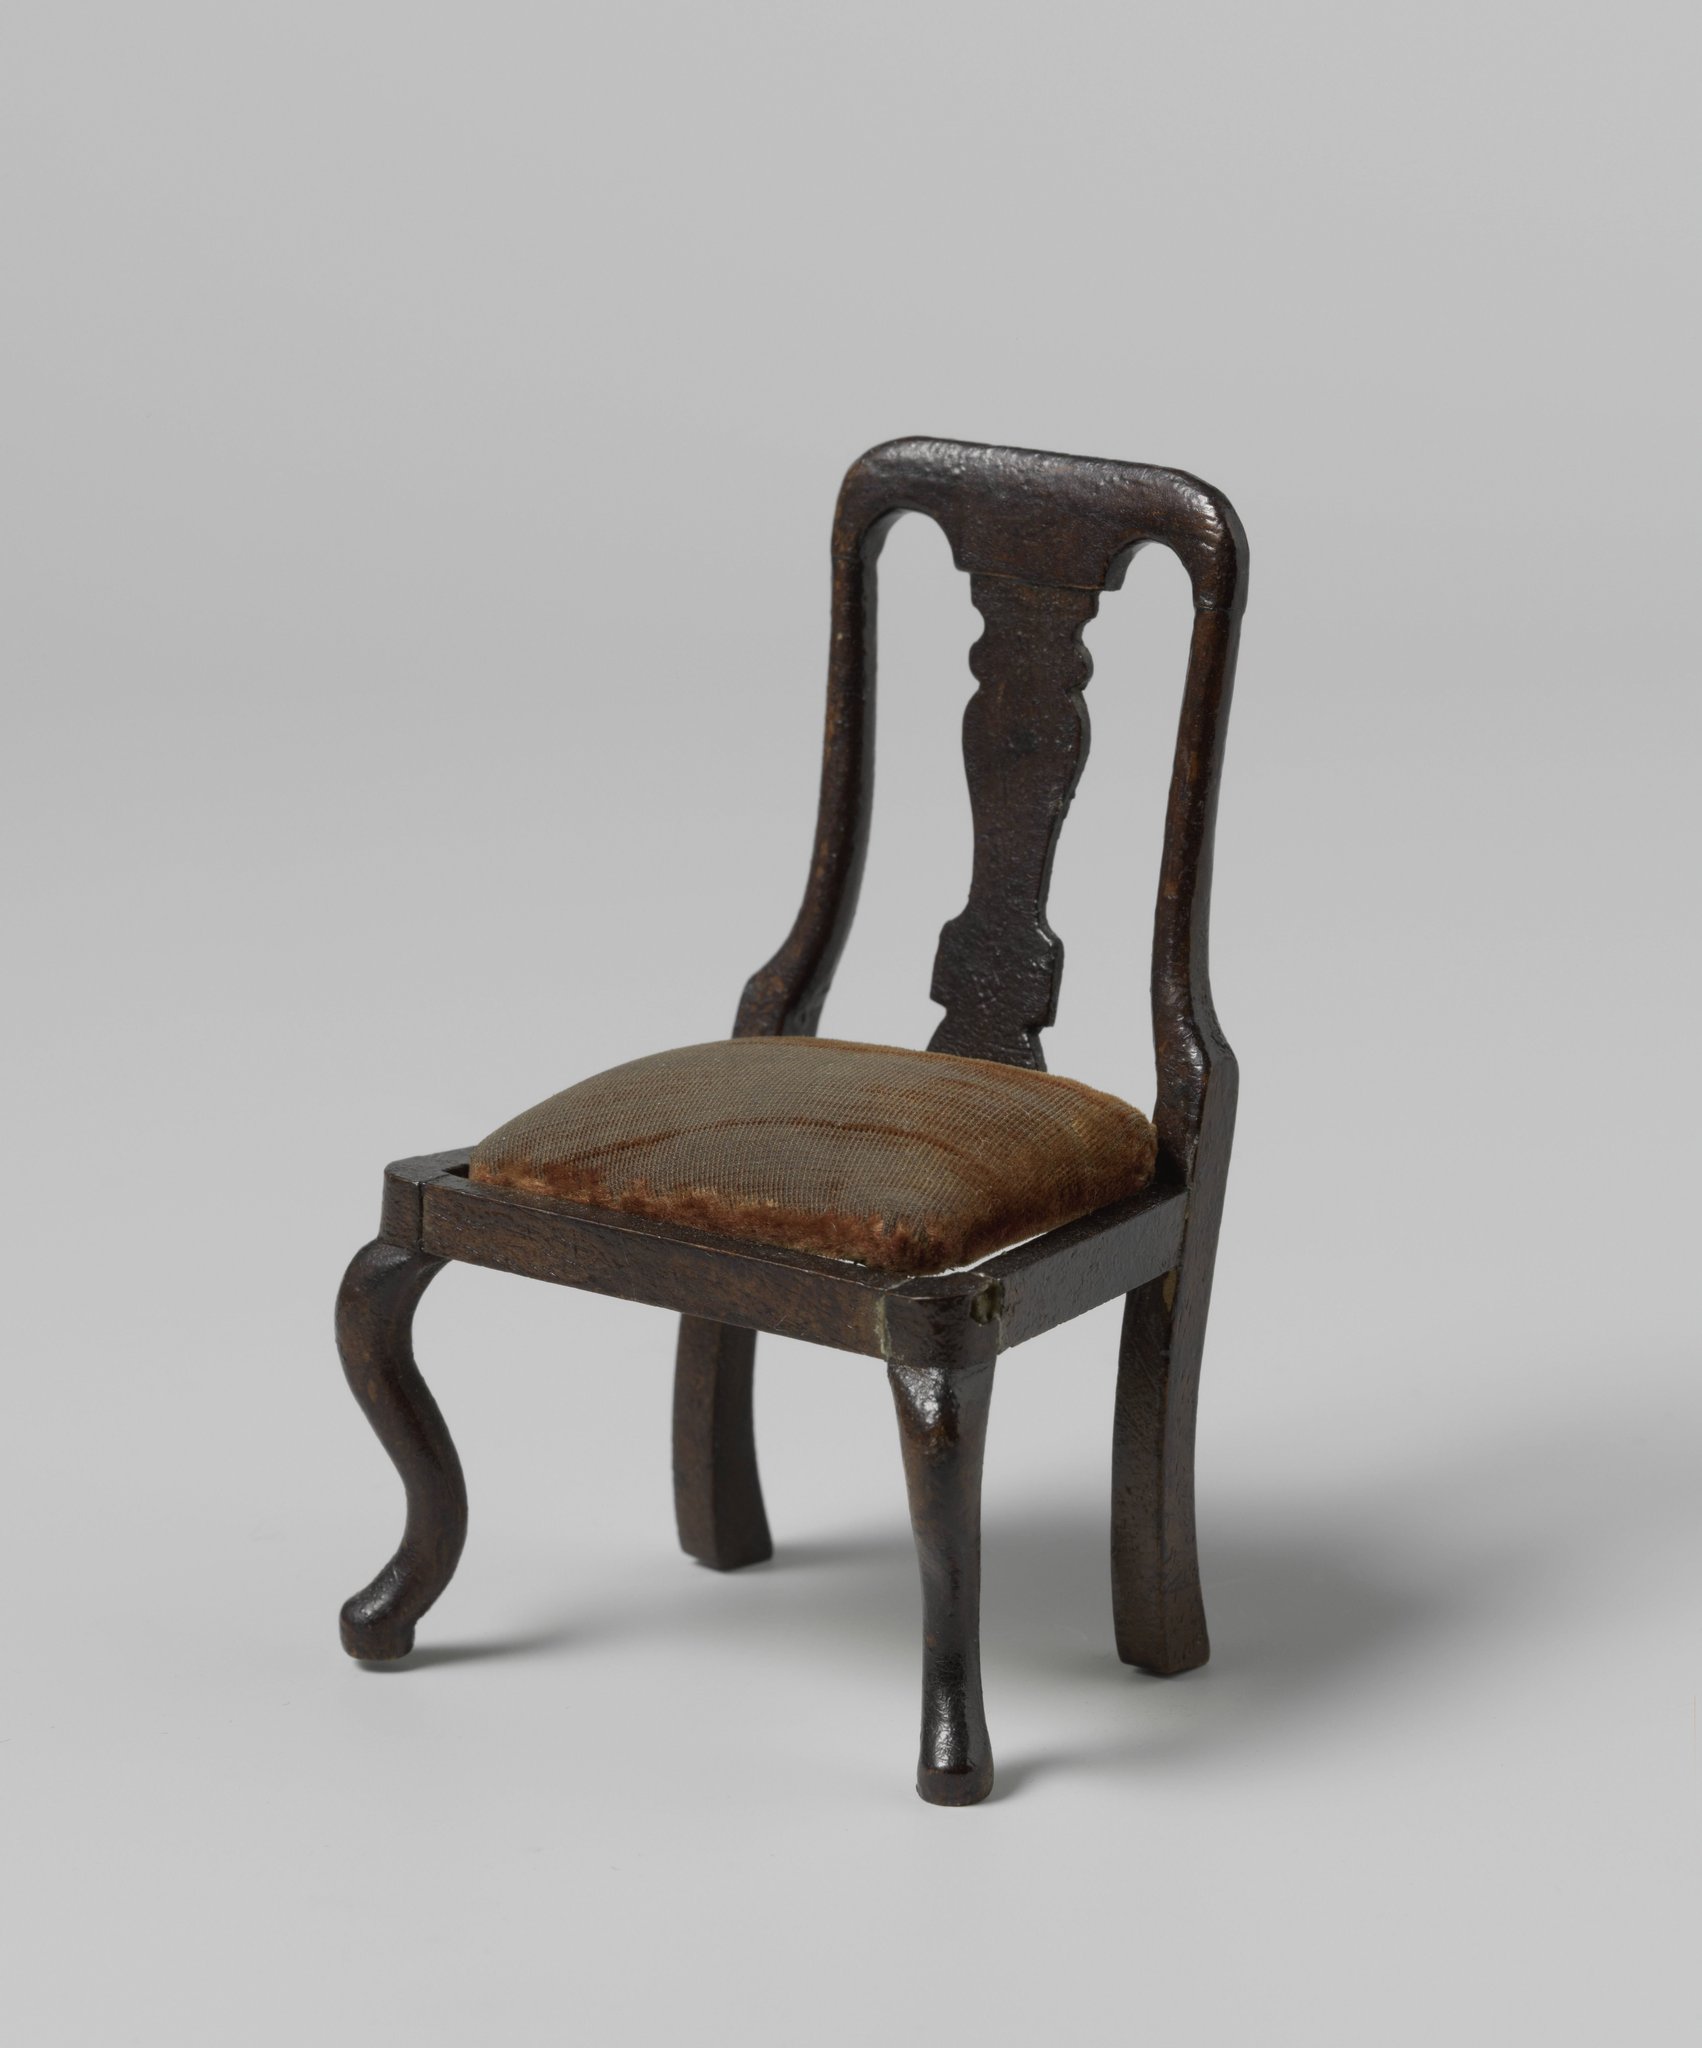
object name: chair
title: Stoel, de rug met vaasvormig middenblad, de zitting met bordeauxrode fluweel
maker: Anonymous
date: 1800-1899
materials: wood, velvet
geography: amsterdam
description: Stoel van mahoniehout. De rug is open met een vaasvormig middenblad. De stoel heeft een trapezium-vormig open zitraam met losse zitting met bordeauxrode fluweel.